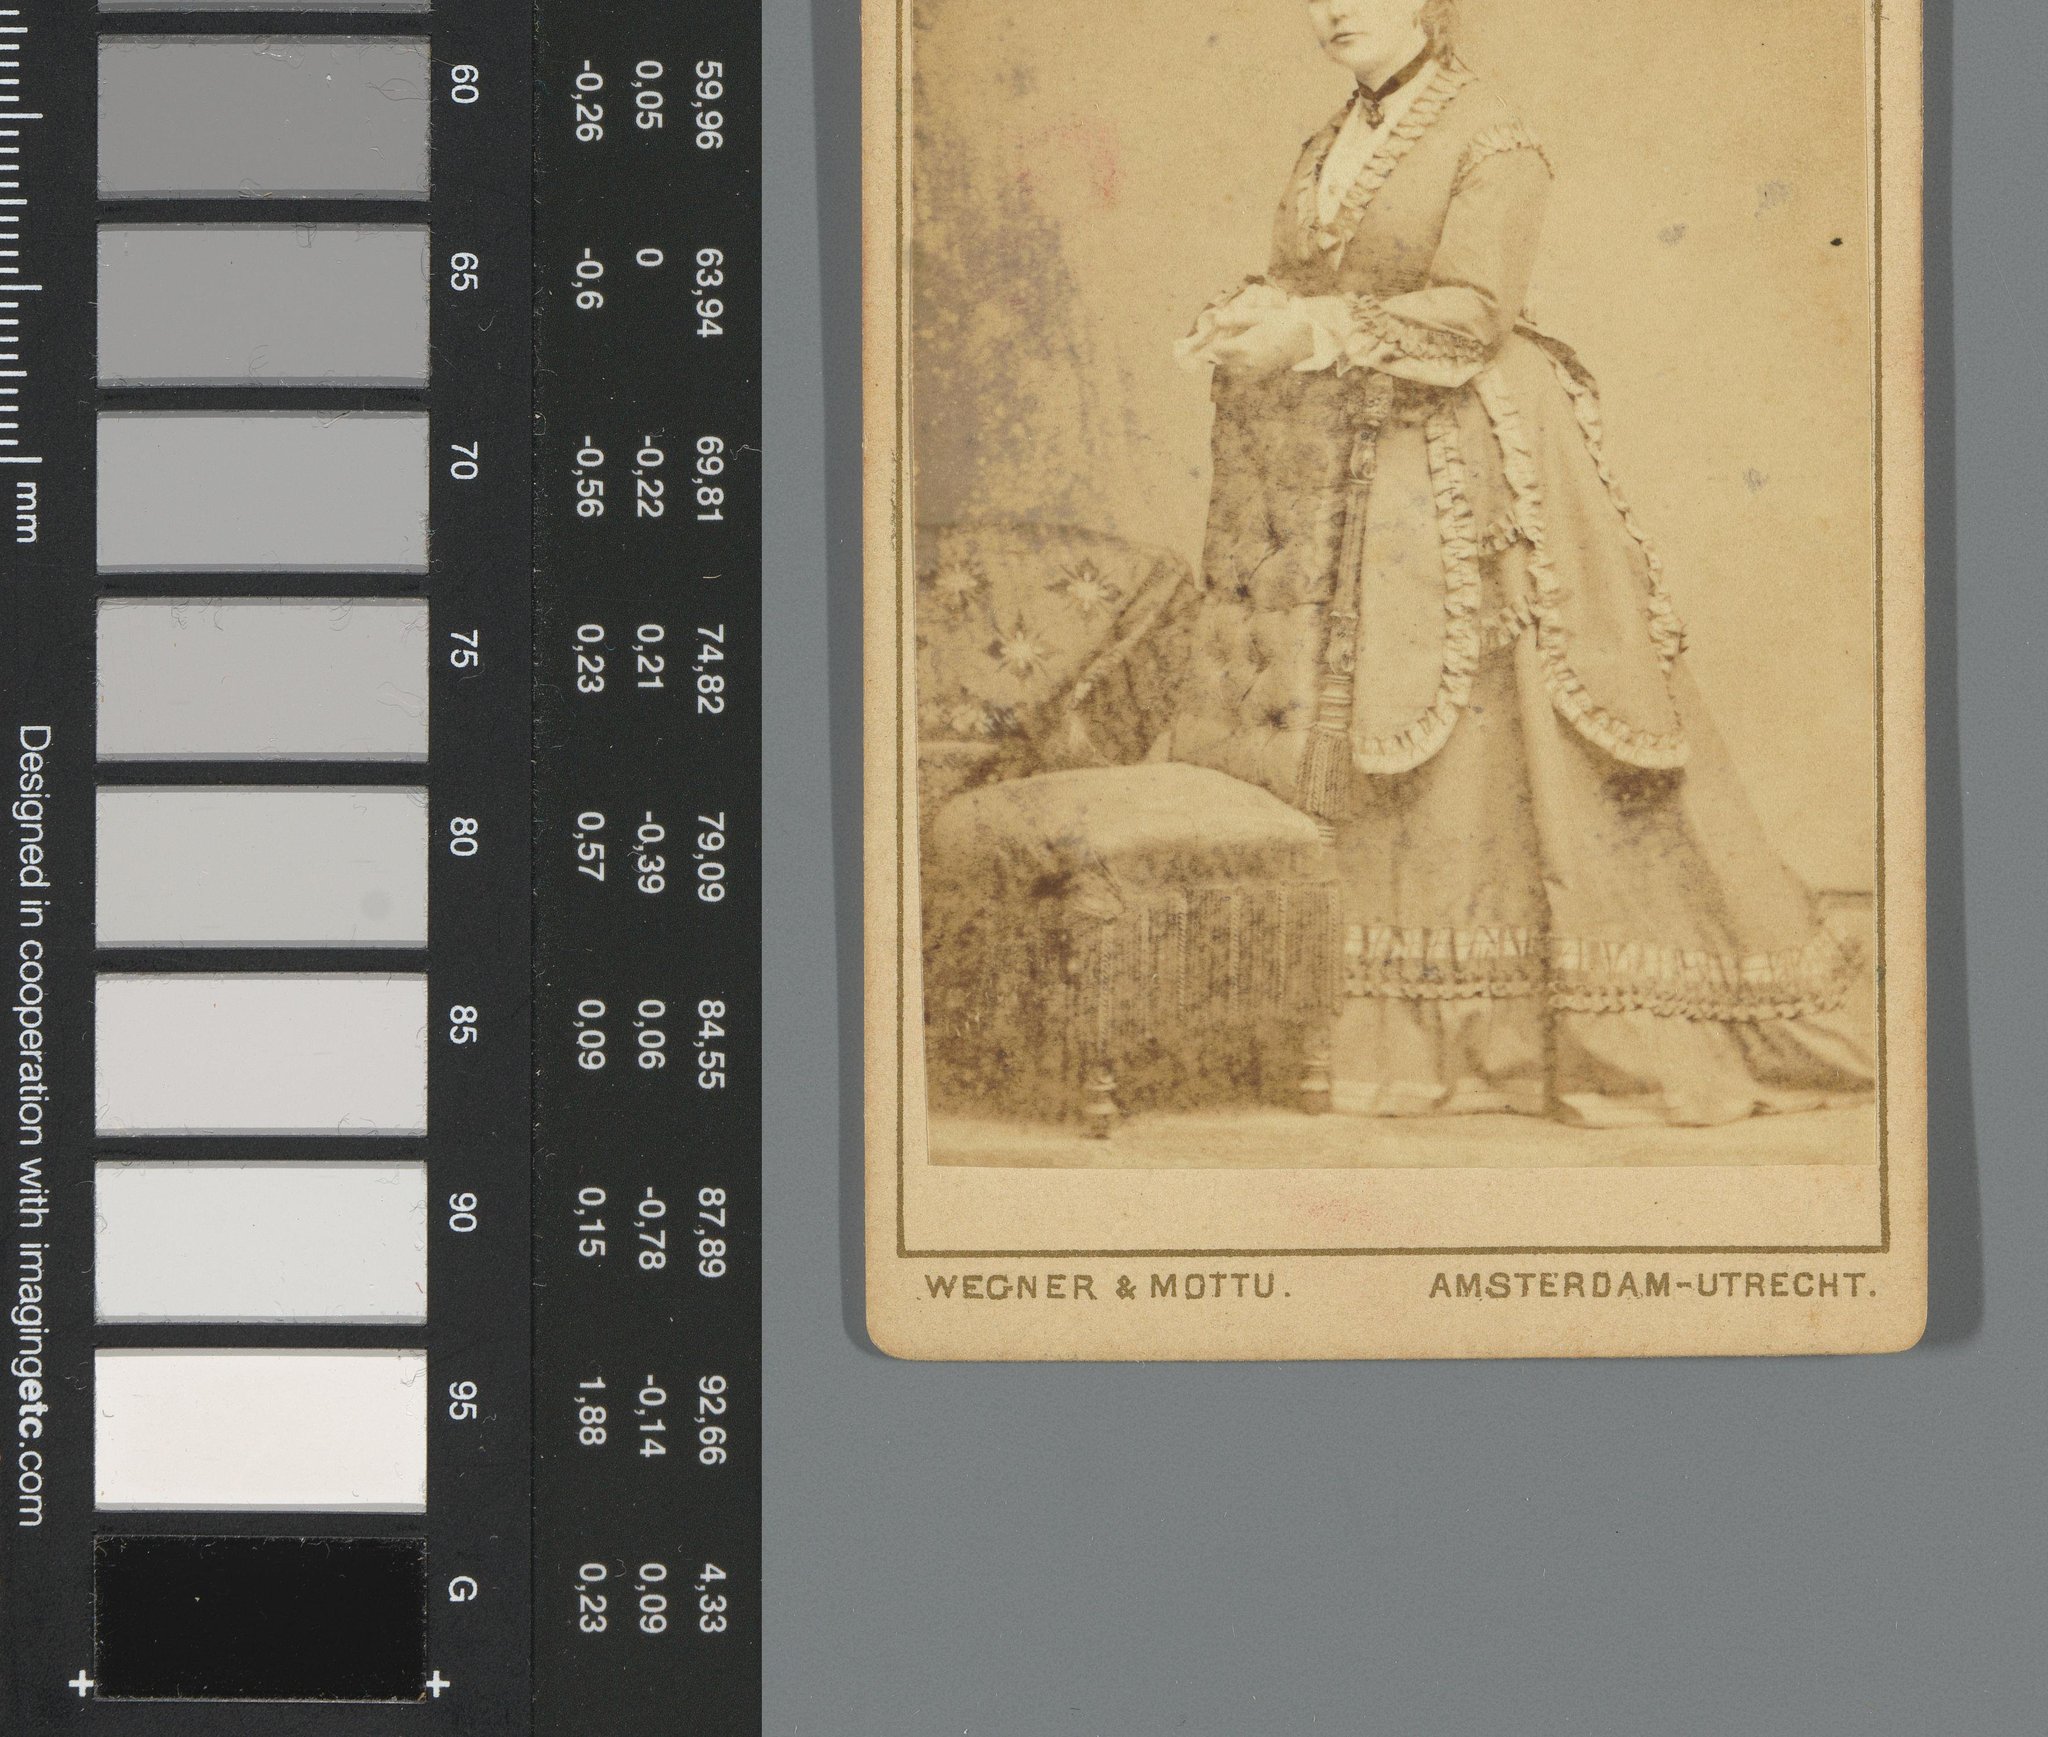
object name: carte de visite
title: Portret van Henriette Teding van Berkhout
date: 1868-1885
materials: cardboard, photographic support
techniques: photography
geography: netherlands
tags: historical persons - bb - woman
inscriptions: annotation: ‘H. de Clercq-TvB’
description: Portret van Henriette de Clercq-Teding van Berkhout. Staande ten voeten uit, de handen op de rug van een stoel.